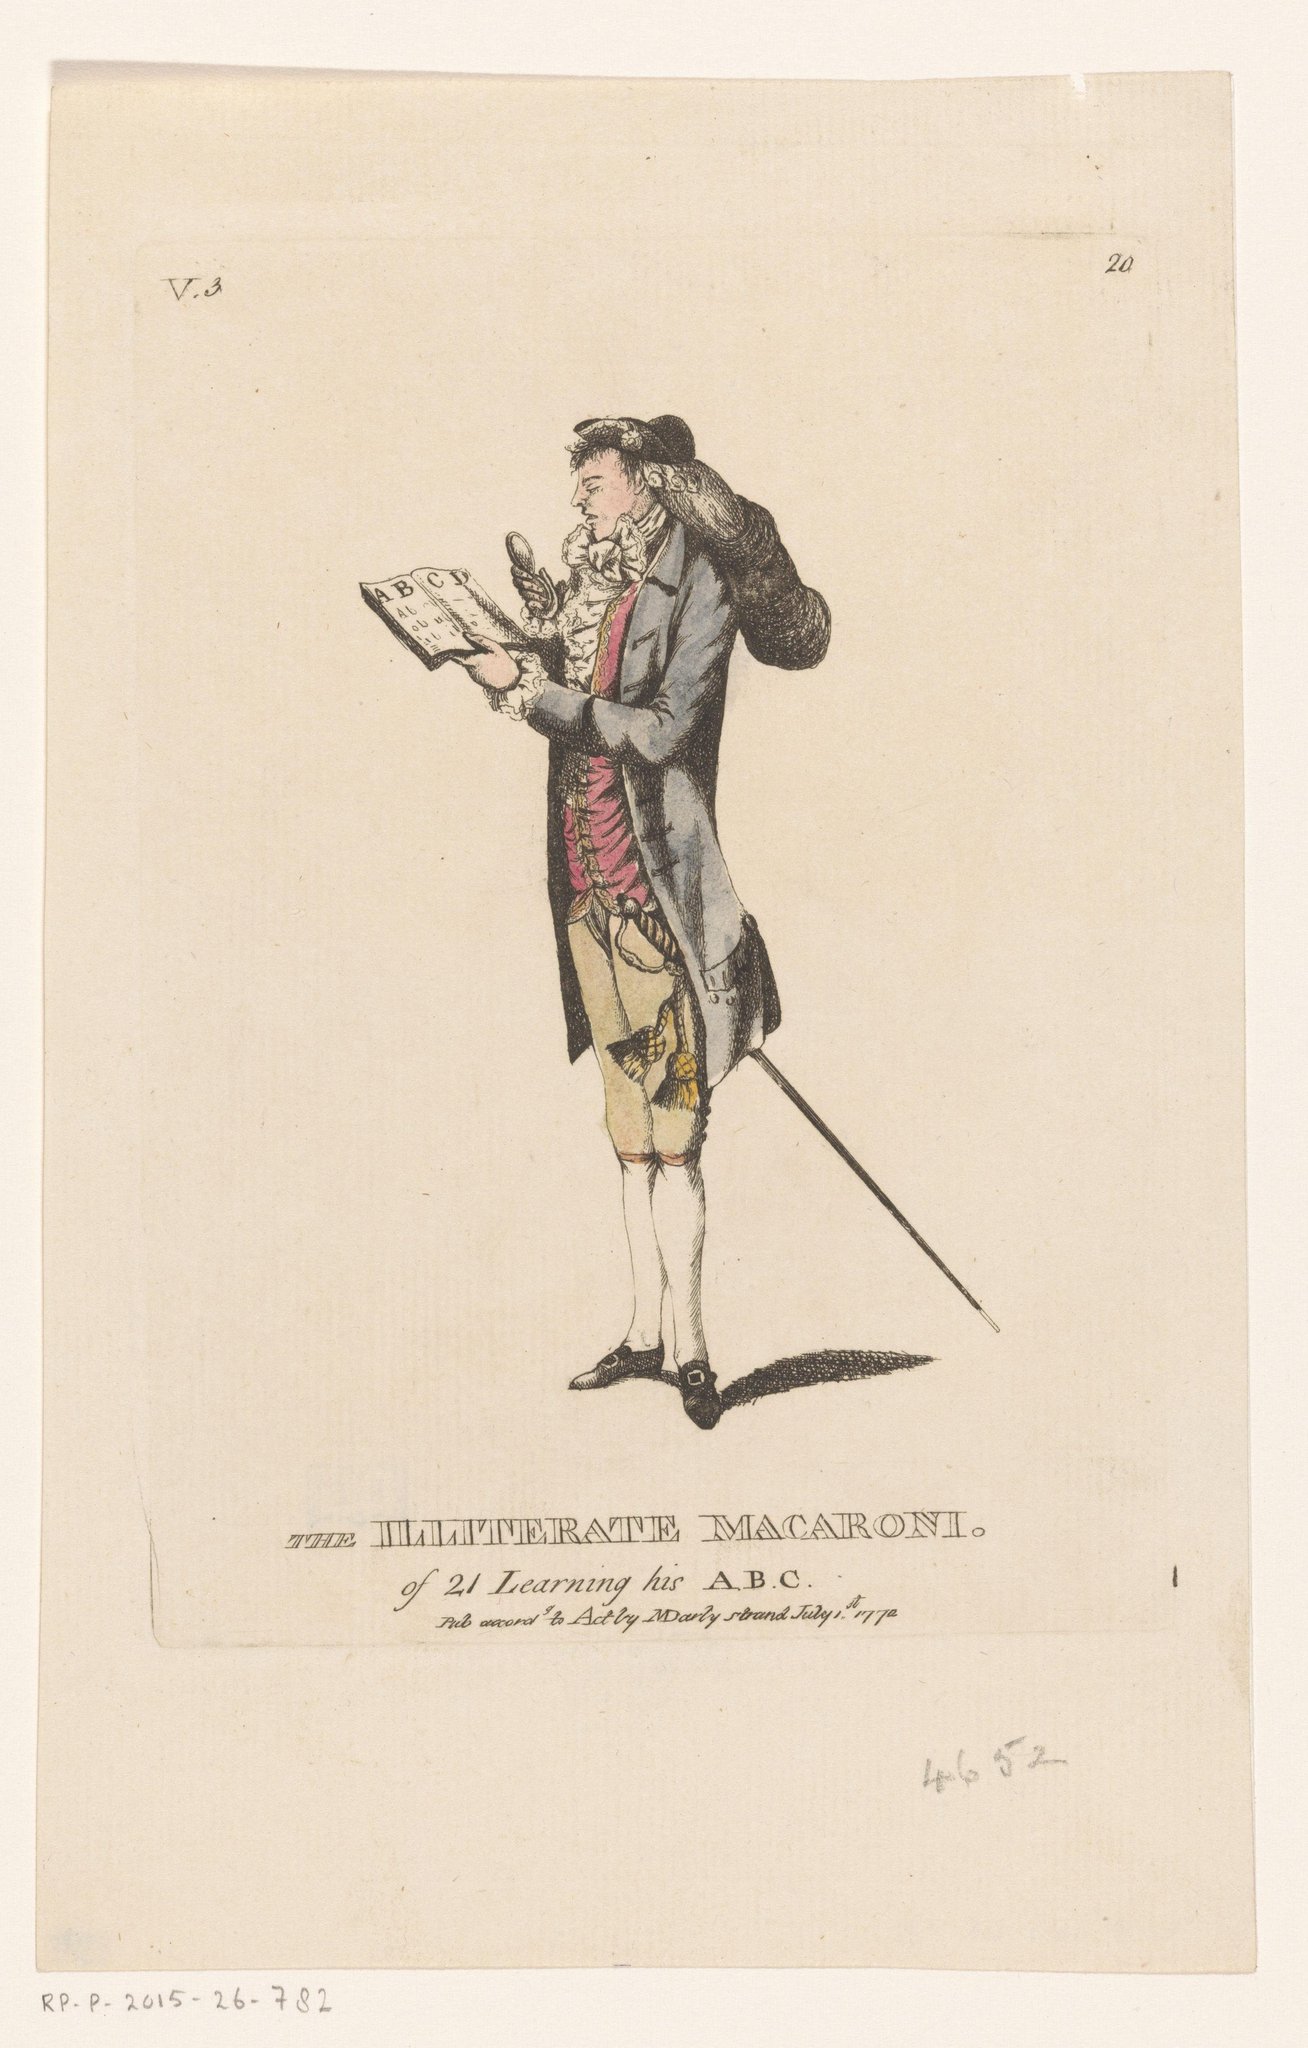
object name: print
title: Ongeletterde Macaroni leert het ABC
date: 1707-1772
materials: paper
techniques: etching, hand coloring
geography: london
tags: earl, caricatures (human types), book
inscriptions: watermark, collector's mark: Lugt 2228, collector's mark: Lugt 4780, collector's mark: Lugt 4779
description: Afkomstig uit de derde serie van zes, getiteld: Macaronies, Characters, Caricatures &cd, uitgegeven door Matthew Darly in Londen tussen 1771 en 1773. De term 'macaronie' werd gebruikt in Engeland in de tweede helft van de 18de eeuw voor personen die op een overdreven wijze de laatste mode volgden. In zekere zin vormden zij de voorlopers van de dandy's. Deze Macaroni stelt Henry Howard, de 12e graaf van Suffolk voor.